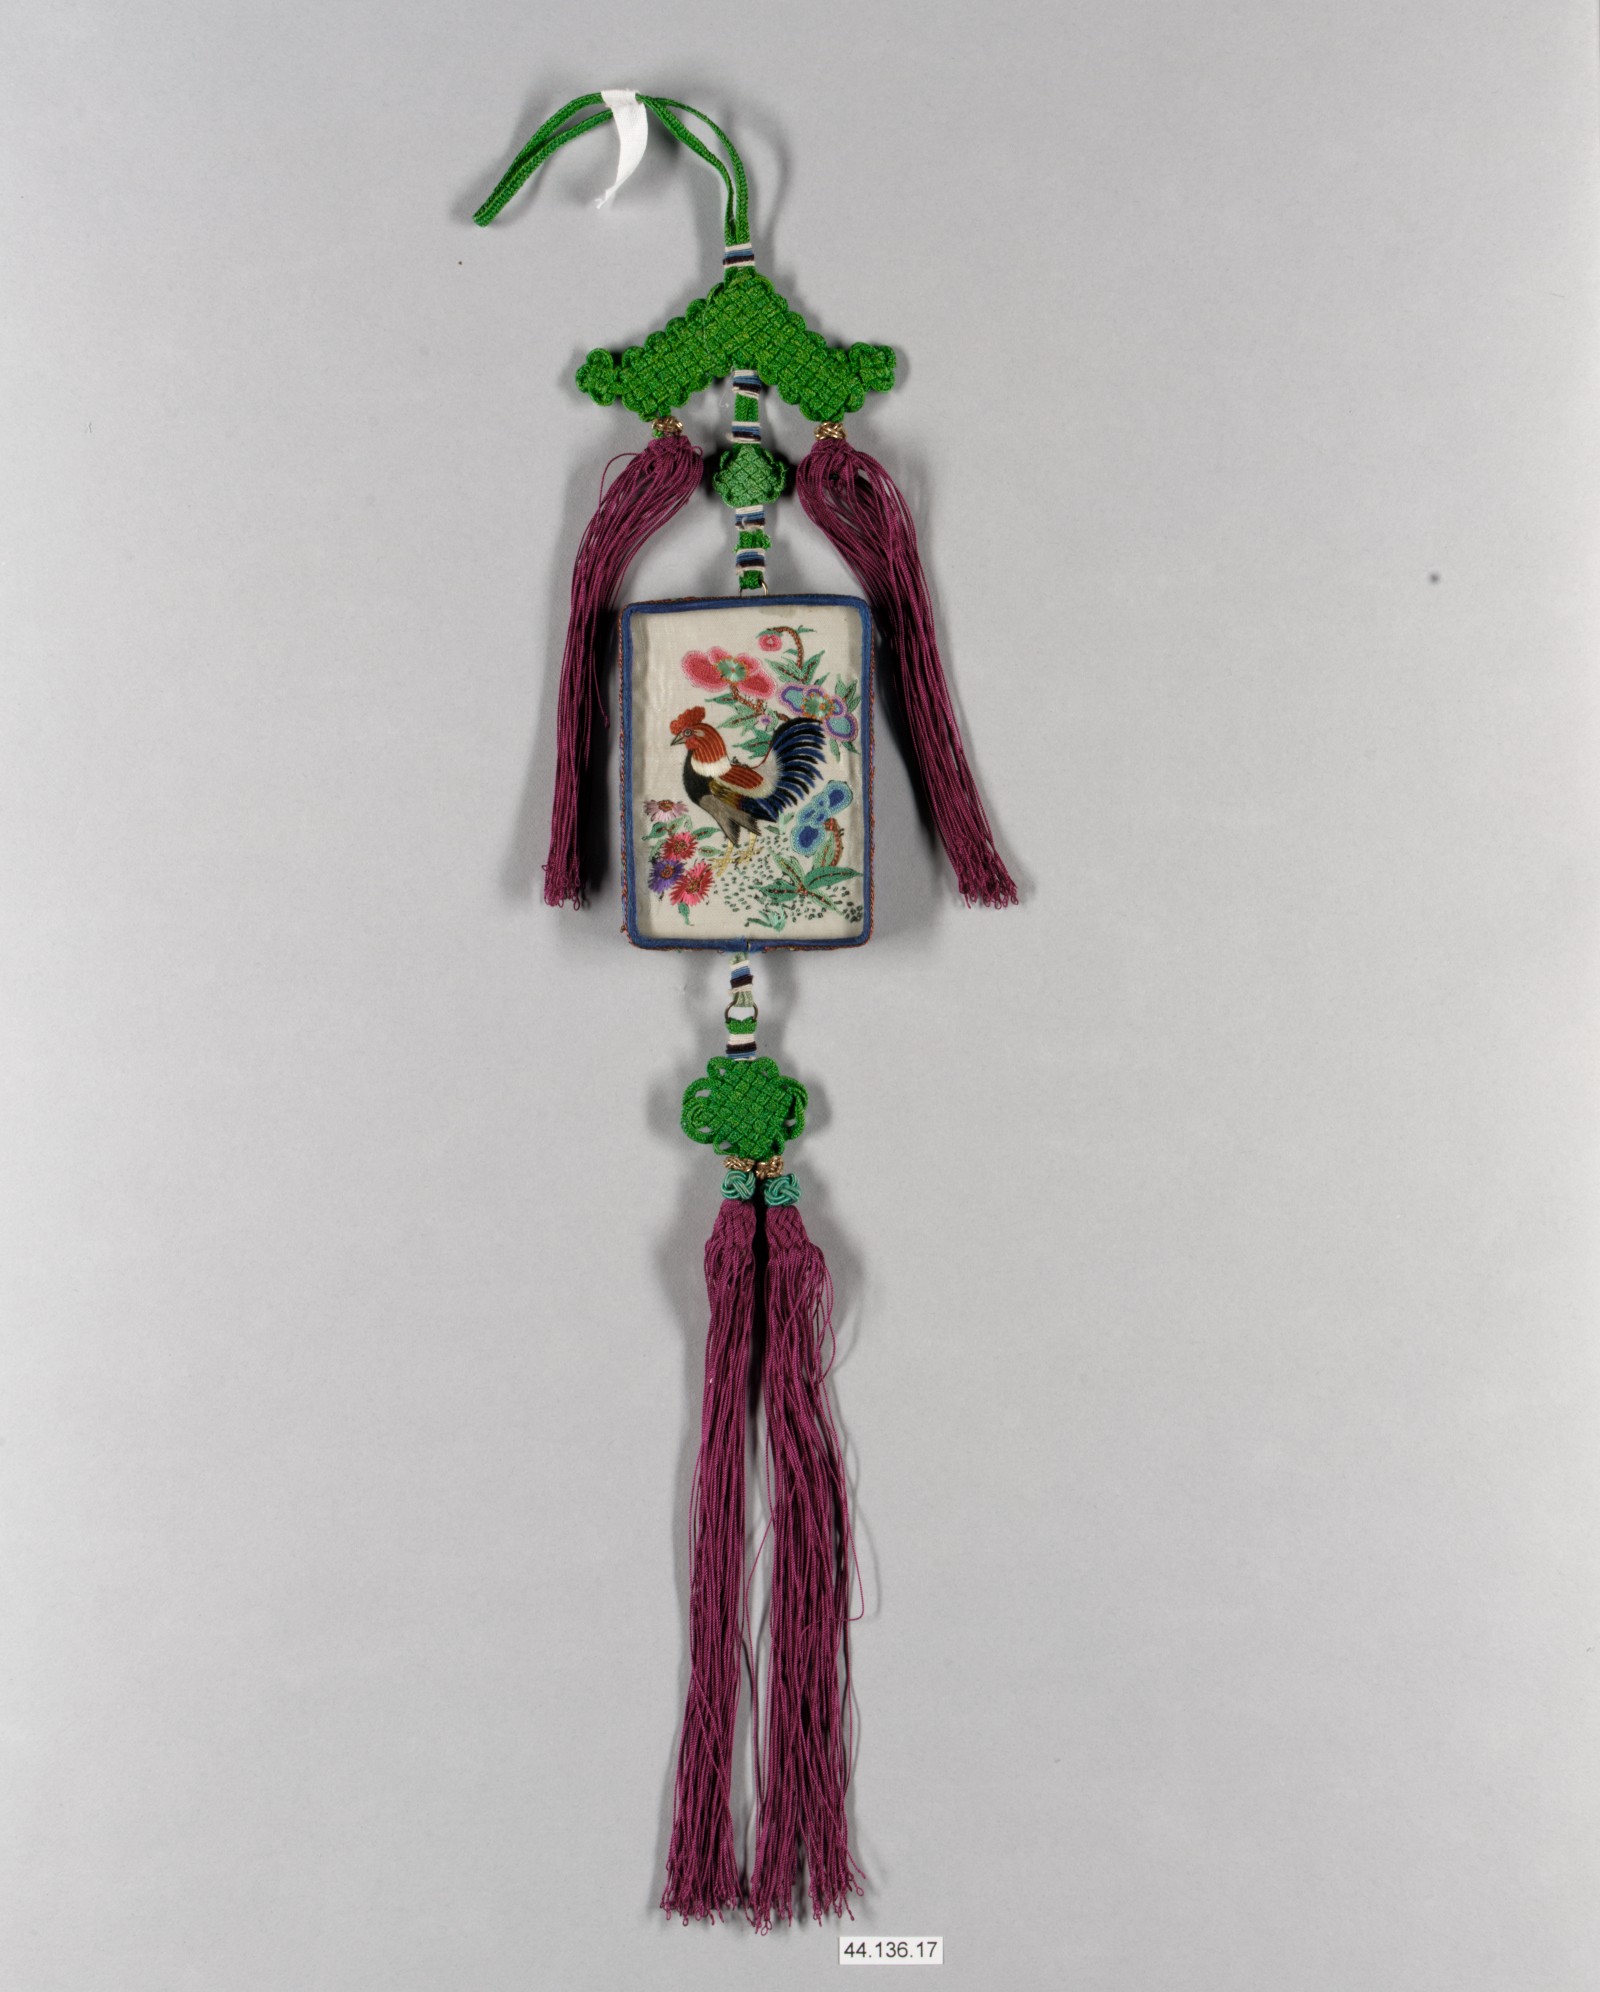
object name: mirror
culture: chinese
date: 1801-1900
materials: glass, metal thread, silk